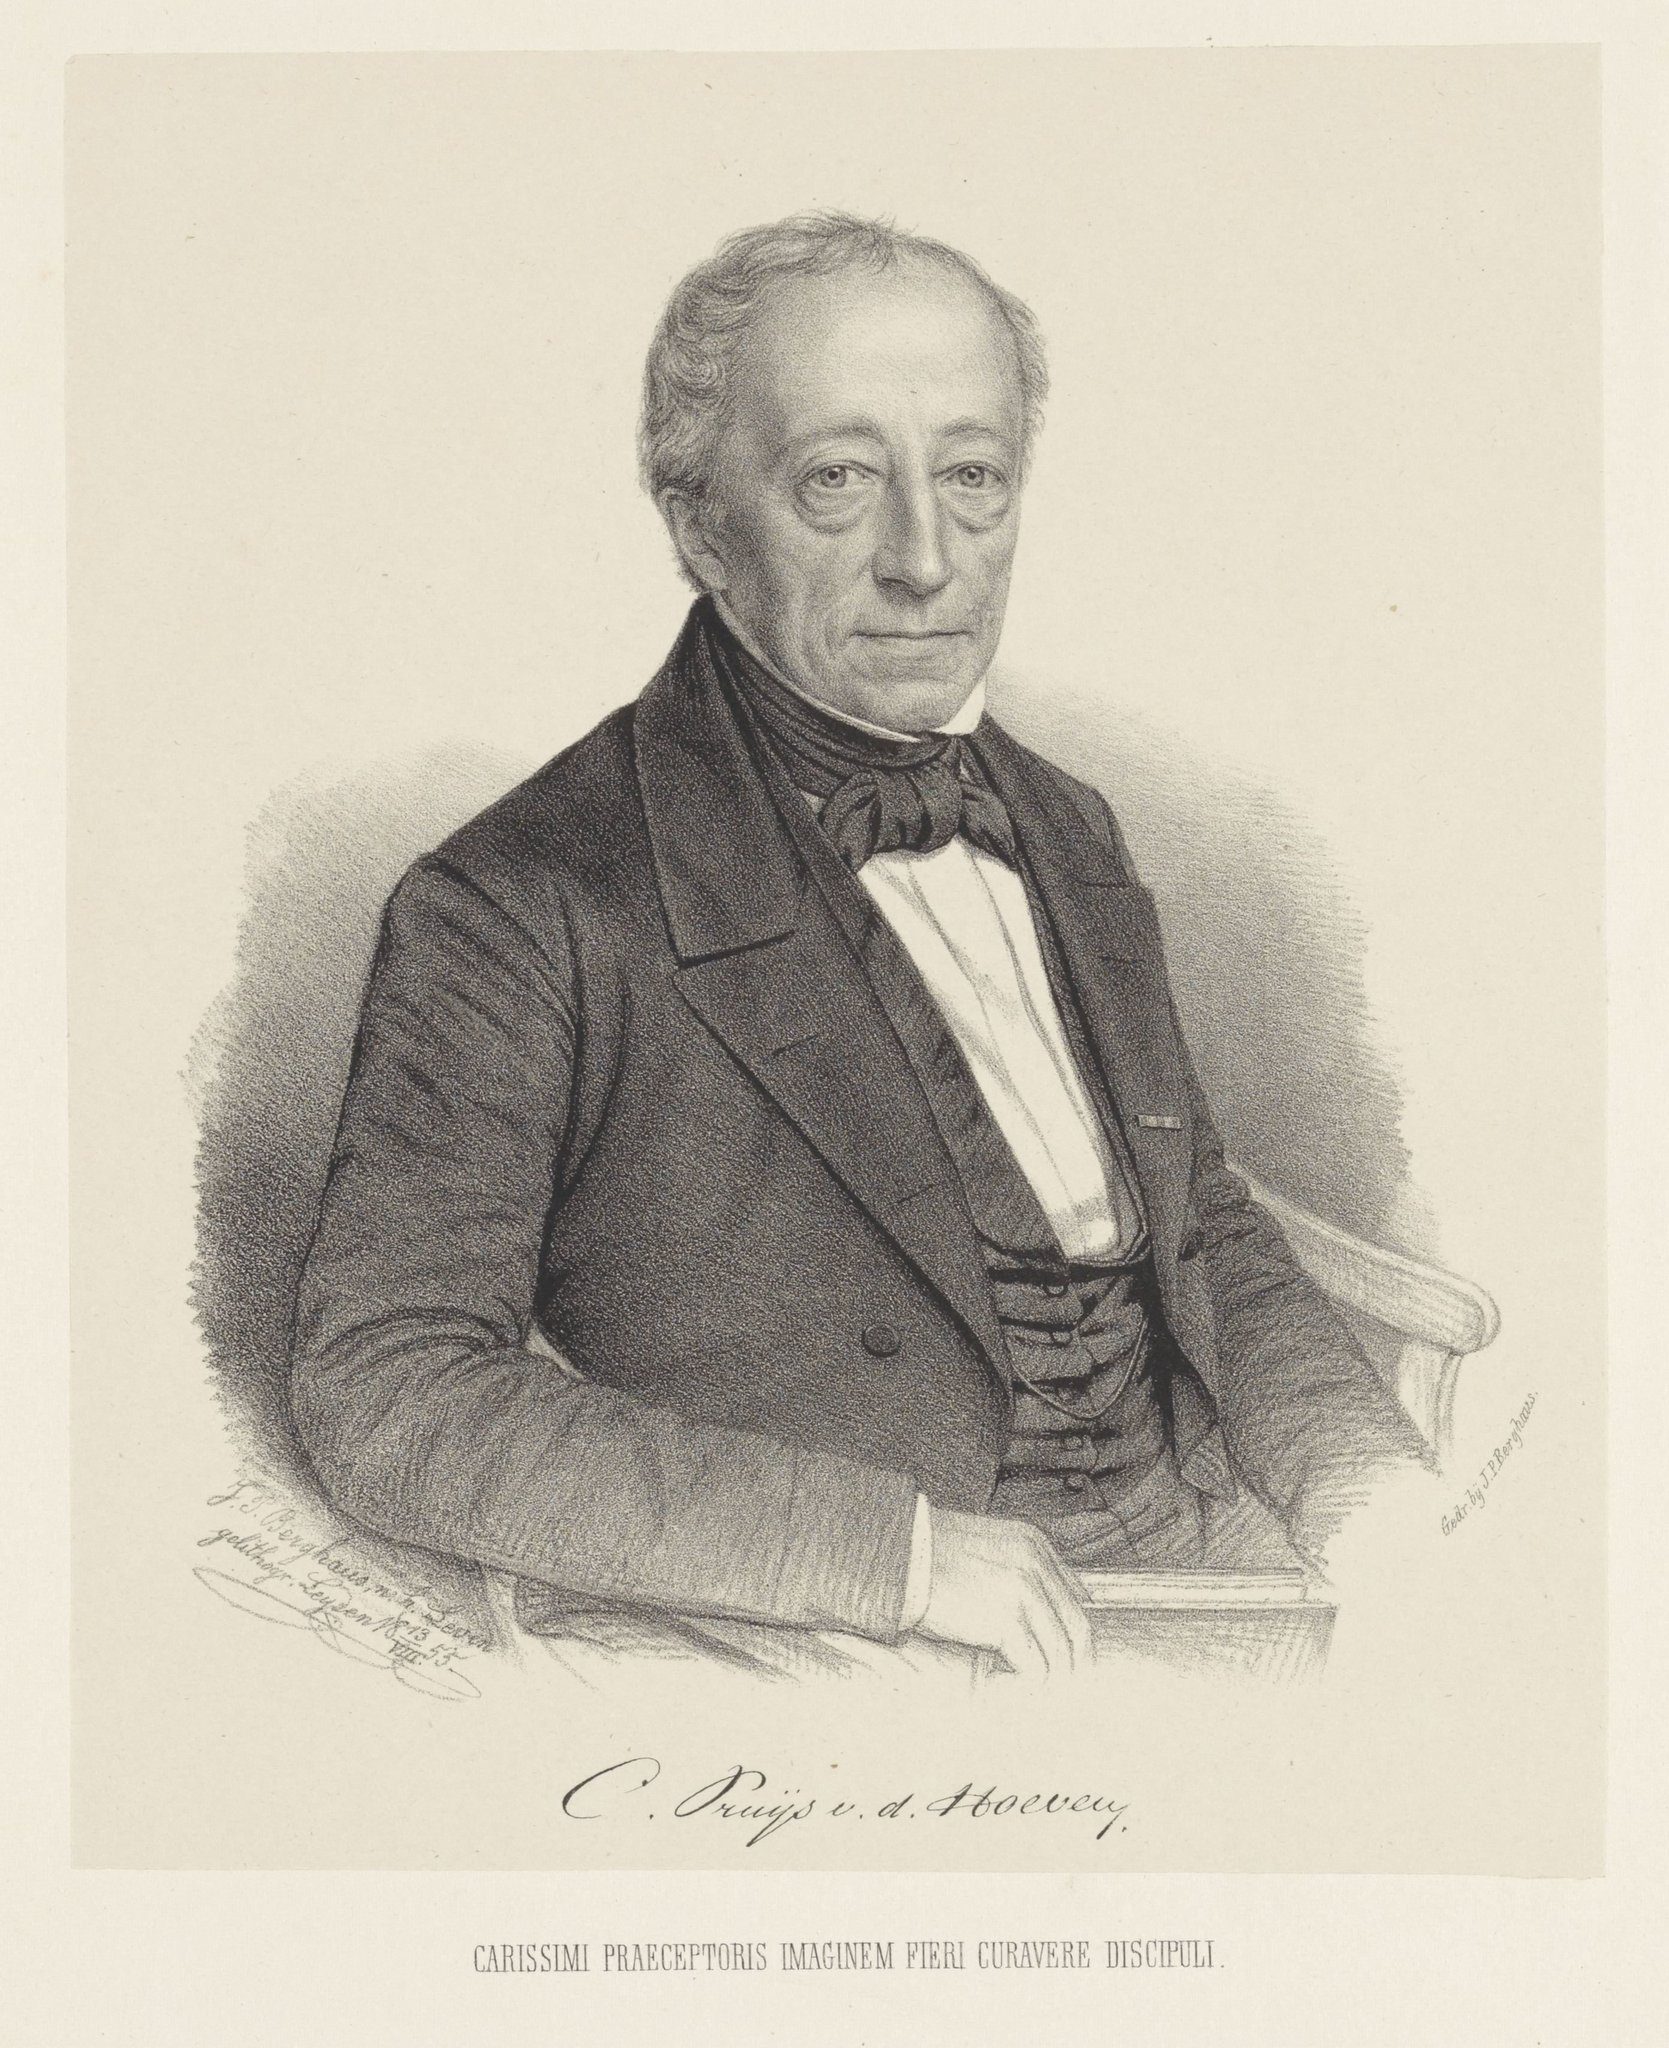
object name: print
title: Portret van Cornelis Pruys van der Hoeven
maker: johann peter berghaus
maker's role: print maker, printer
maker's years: 1810-1870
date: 1855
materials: paper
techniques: lithograph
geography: leiden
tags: leiden, historical persons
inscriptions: date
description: Onder het portret de signatuur van de geportretteerde en een opdracht in Latijn.